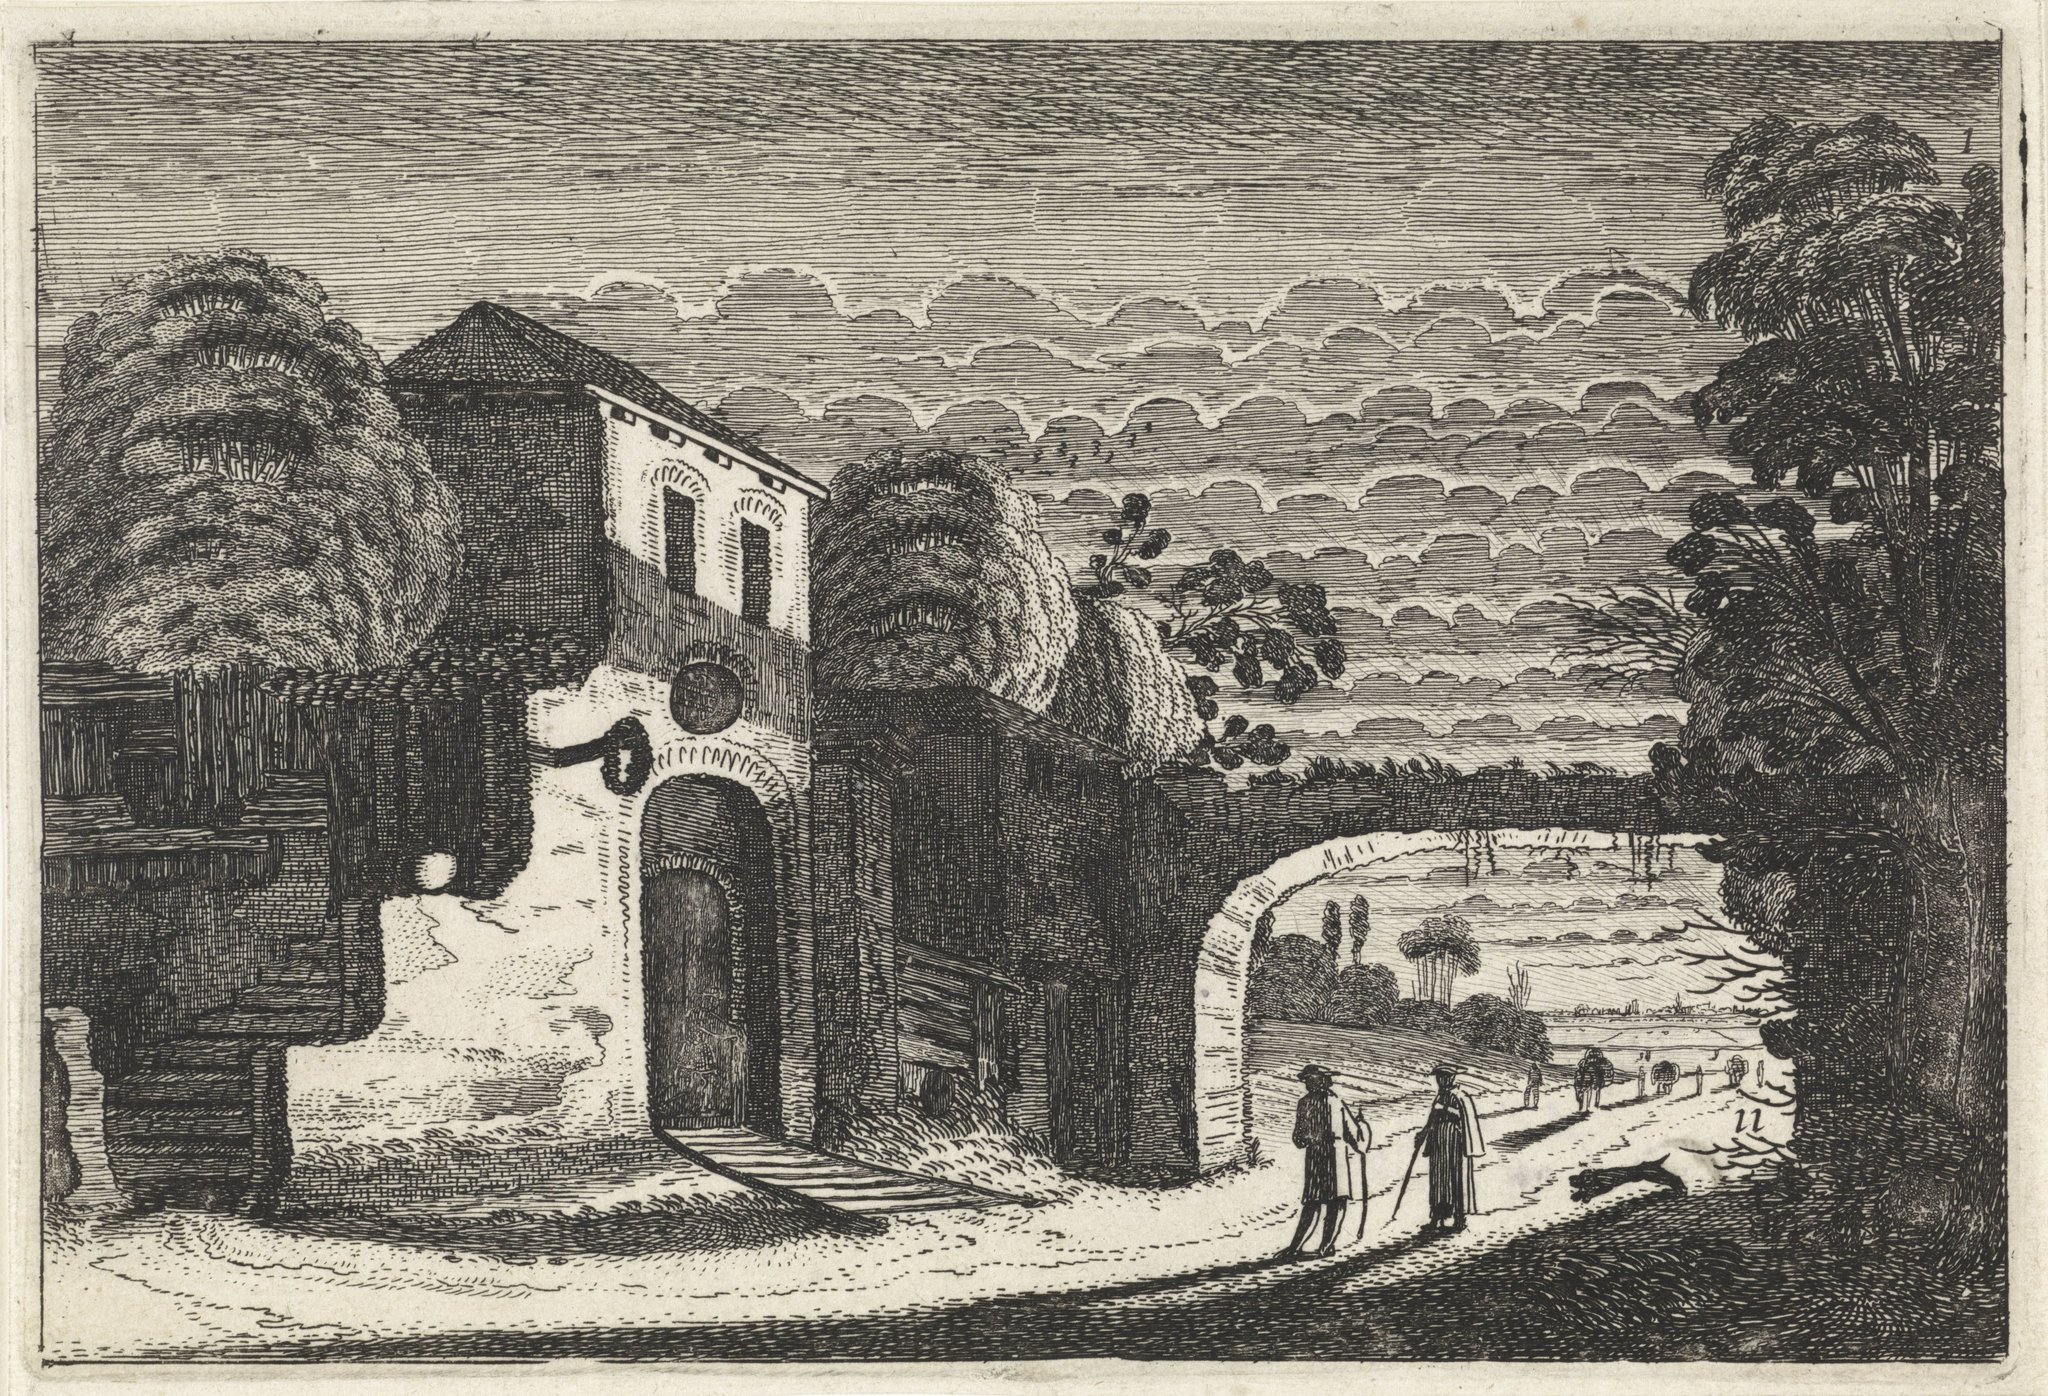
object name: print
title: Landschappen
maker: jan van de velde (ii)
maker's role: draughtsman, painter, print maker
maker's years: 1593-1641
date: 1616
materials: paper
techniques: etching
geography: northern netherlands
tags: dusk, evening twilight, evening, hotel, hostelry, inn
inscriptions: collector's mark: Lugt 964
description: Twee figuren op een pad bij een herberg bij de vallende avond. Elfde prent van een serie van in totaal zestig prenten met landschappen, verdeeld over vijf delen van elk twaalf prenten.